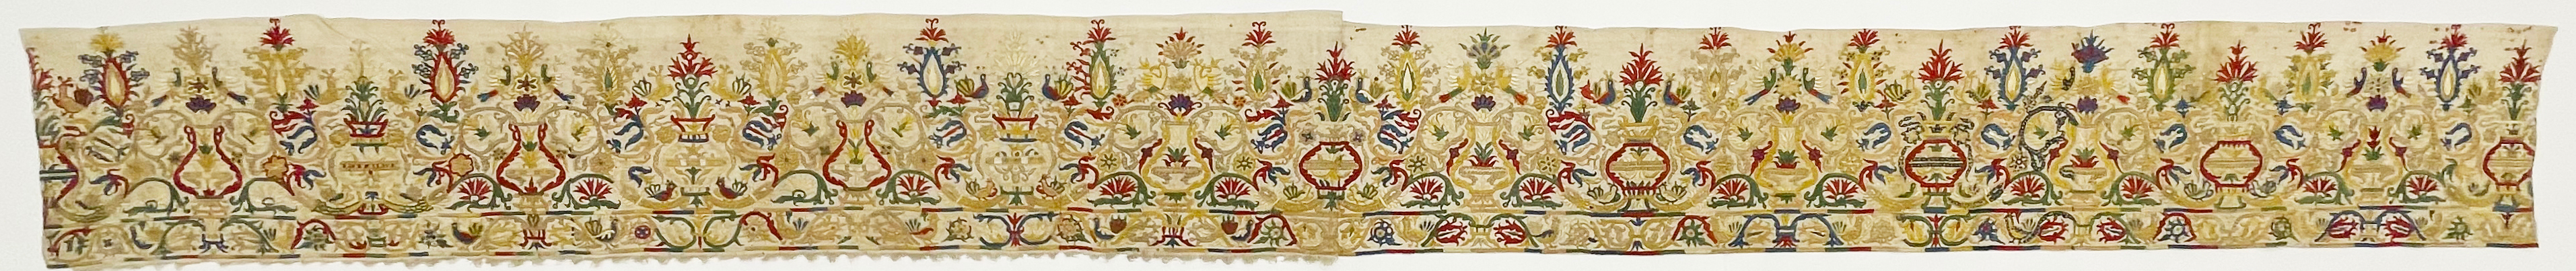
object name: border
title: Dress border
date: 1701-1800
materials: linen